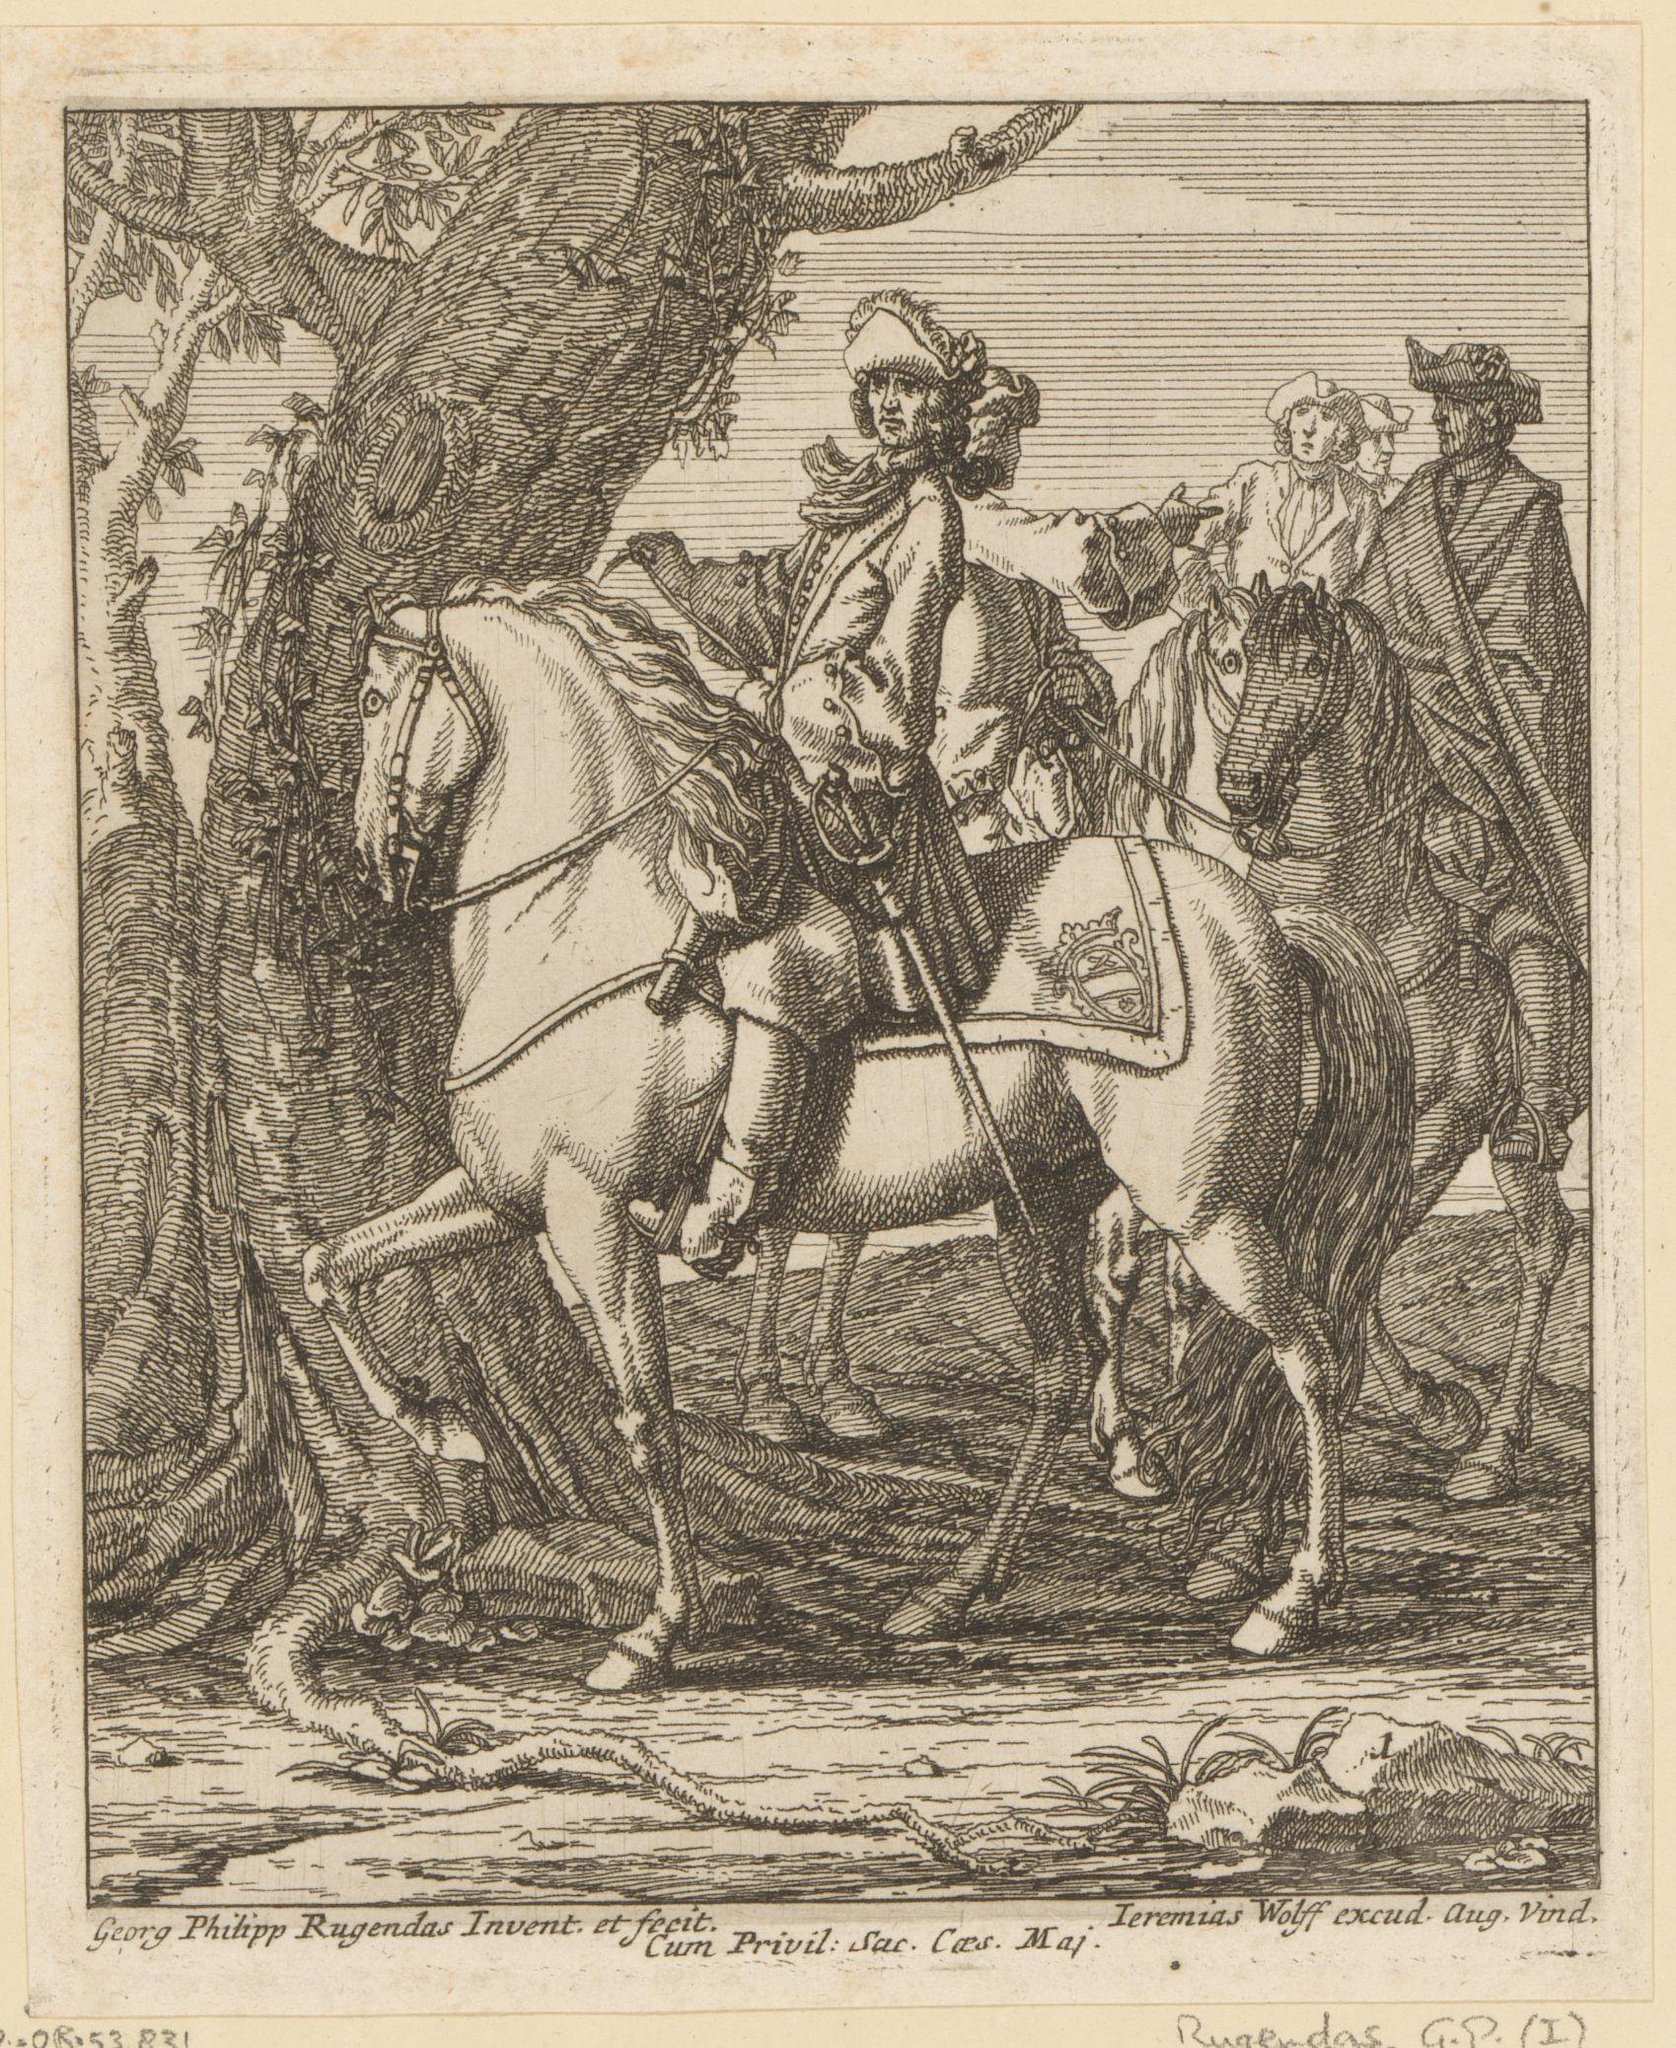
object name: print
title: Groep ruiters bij een boom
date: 1676-1742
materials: paper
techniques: etching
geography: augsburg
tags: riding a horse, ass, or mule; rider, horseman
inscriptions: collector's mark: Lugt 240